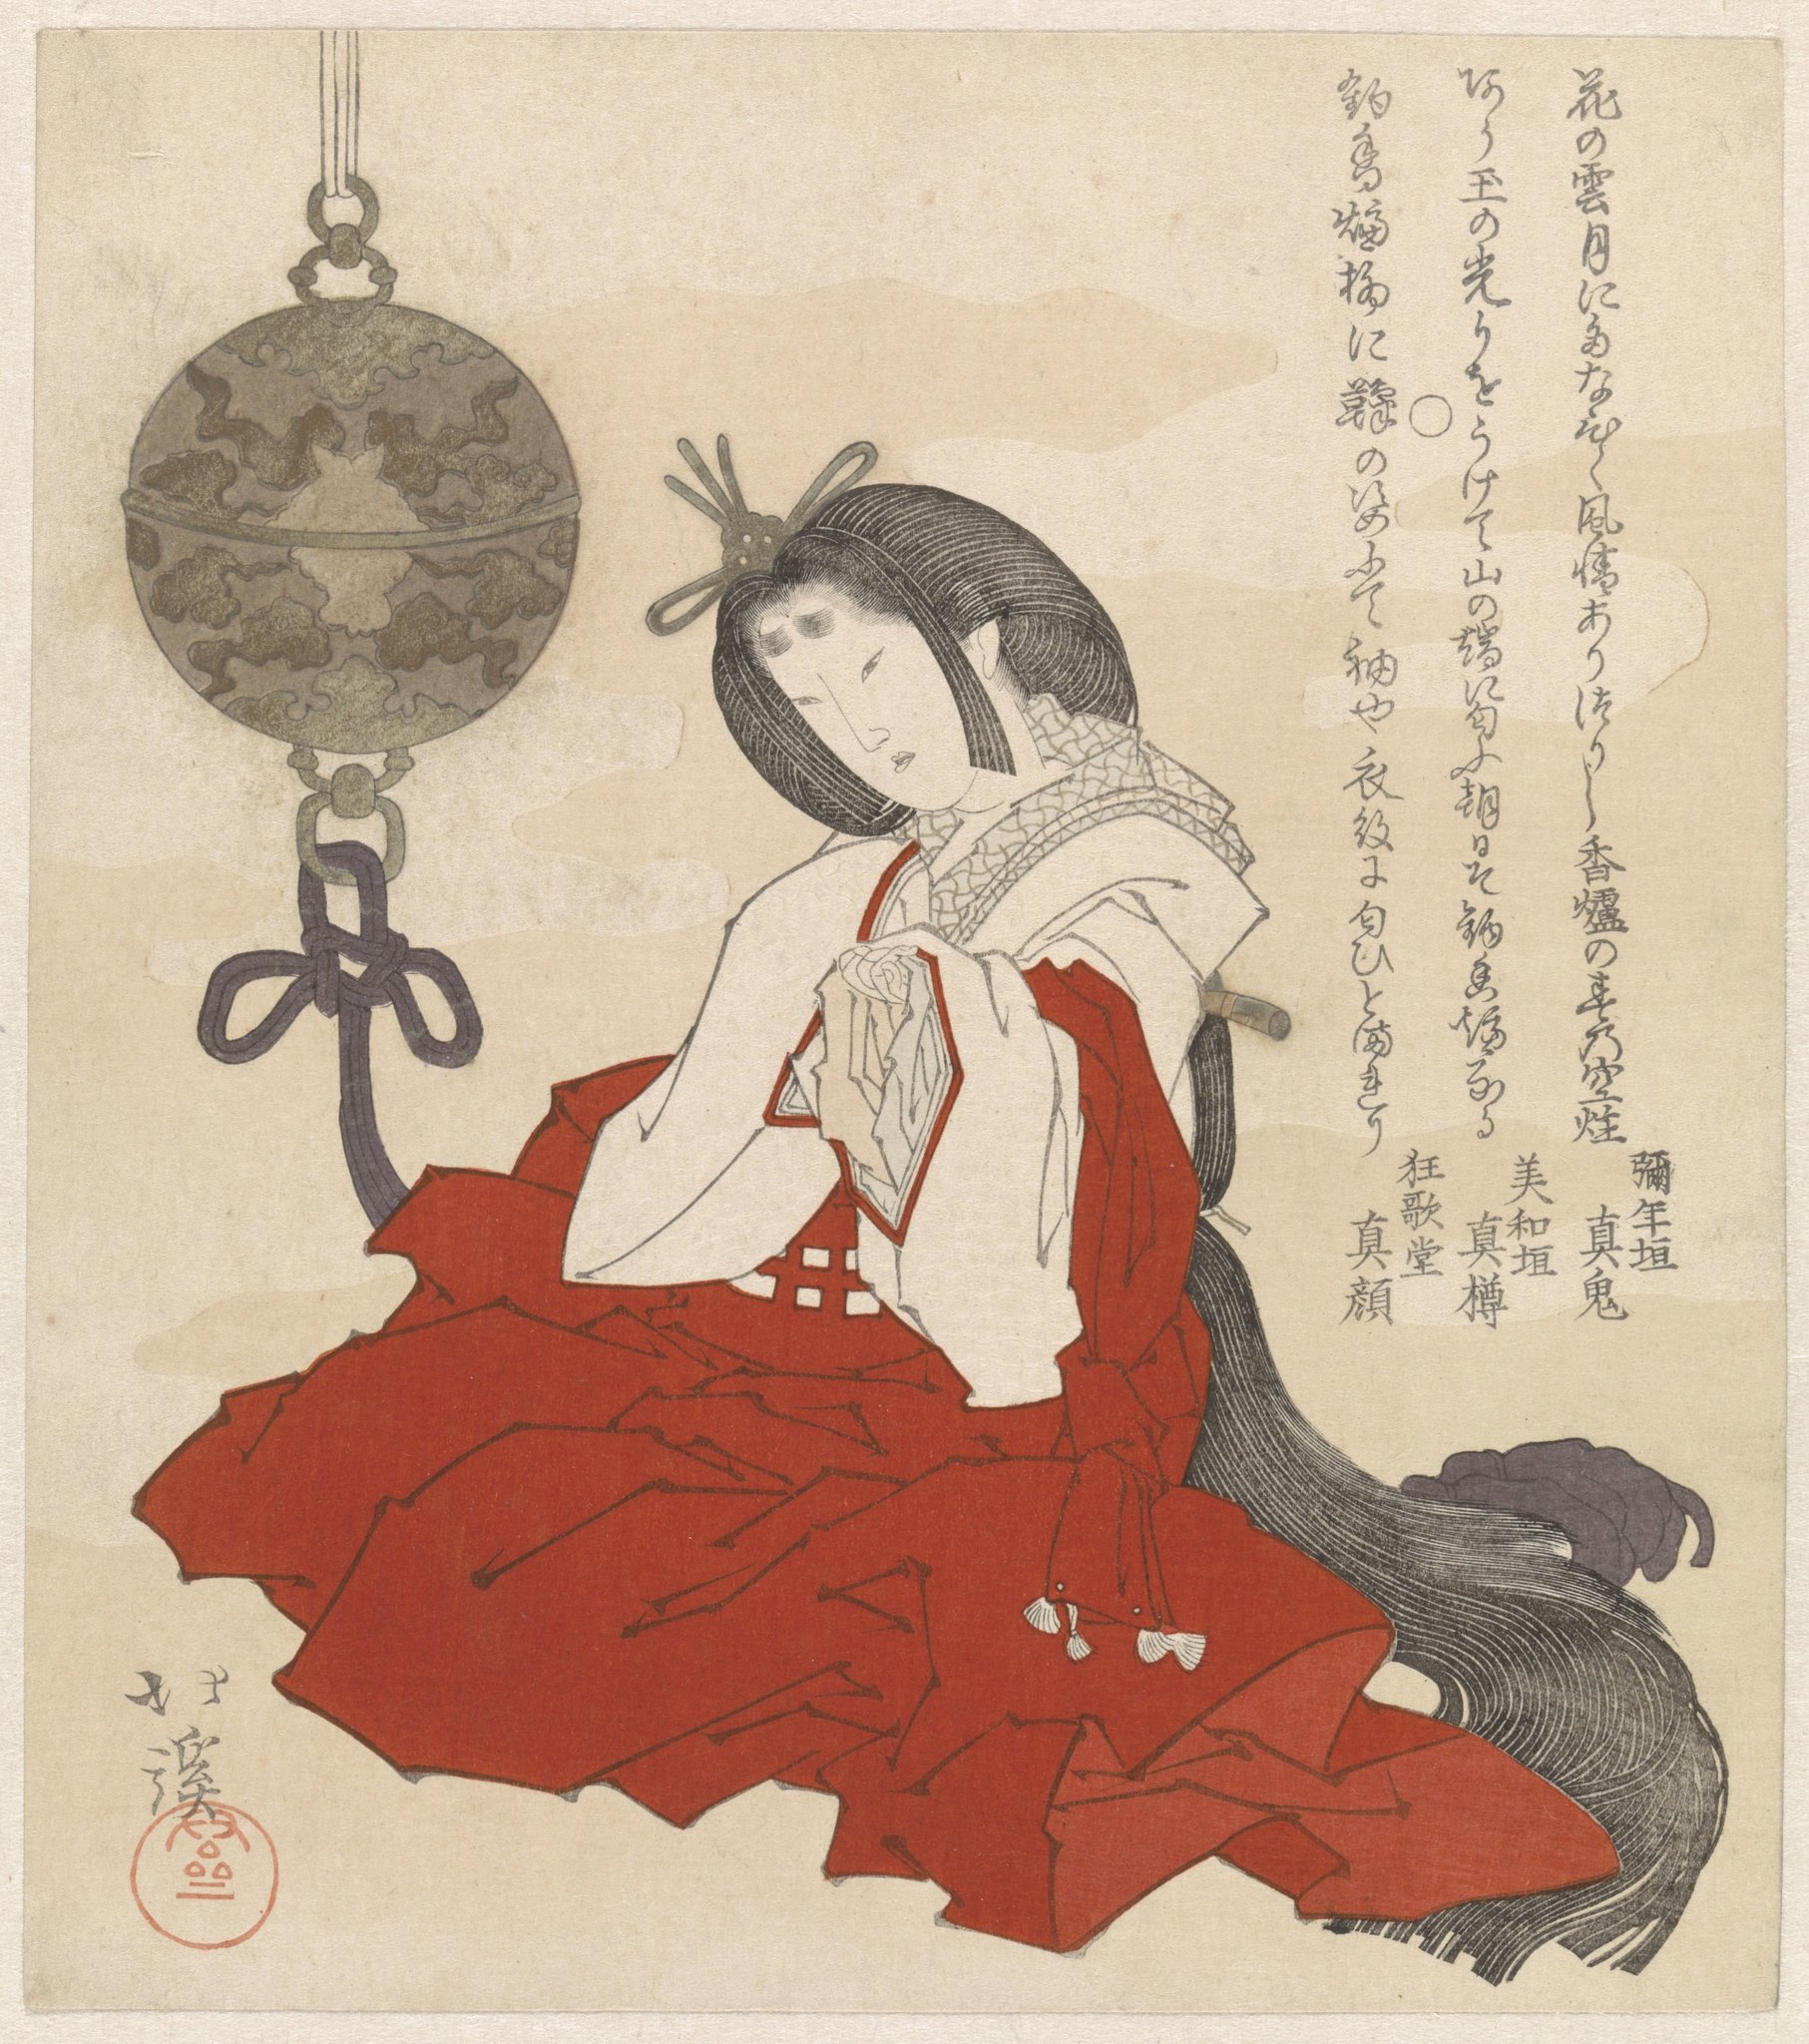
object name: print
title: Vrouw met wierookbrander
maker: totoya hokkei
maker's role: print maker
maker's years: 1790-1850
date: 1800-1850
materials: paper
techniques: blind stamped, woodcut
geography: japan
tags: incense-burner ~ scents, perfumes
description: Een surimono is een luxe uitgevoerde prent waarop beeld met één of meerdere gedichten gecombineerd is. Bij het drukken van een surimono werd vaak gebruik gemaakt van dikker papier, blinddruk en metaal pigmenten, zoals koper- en zilverpoeder. De prenten werden vaak in opdracht van dichters gemaakt en als exclusief geschenk aan vrienden en relaties gegeven.